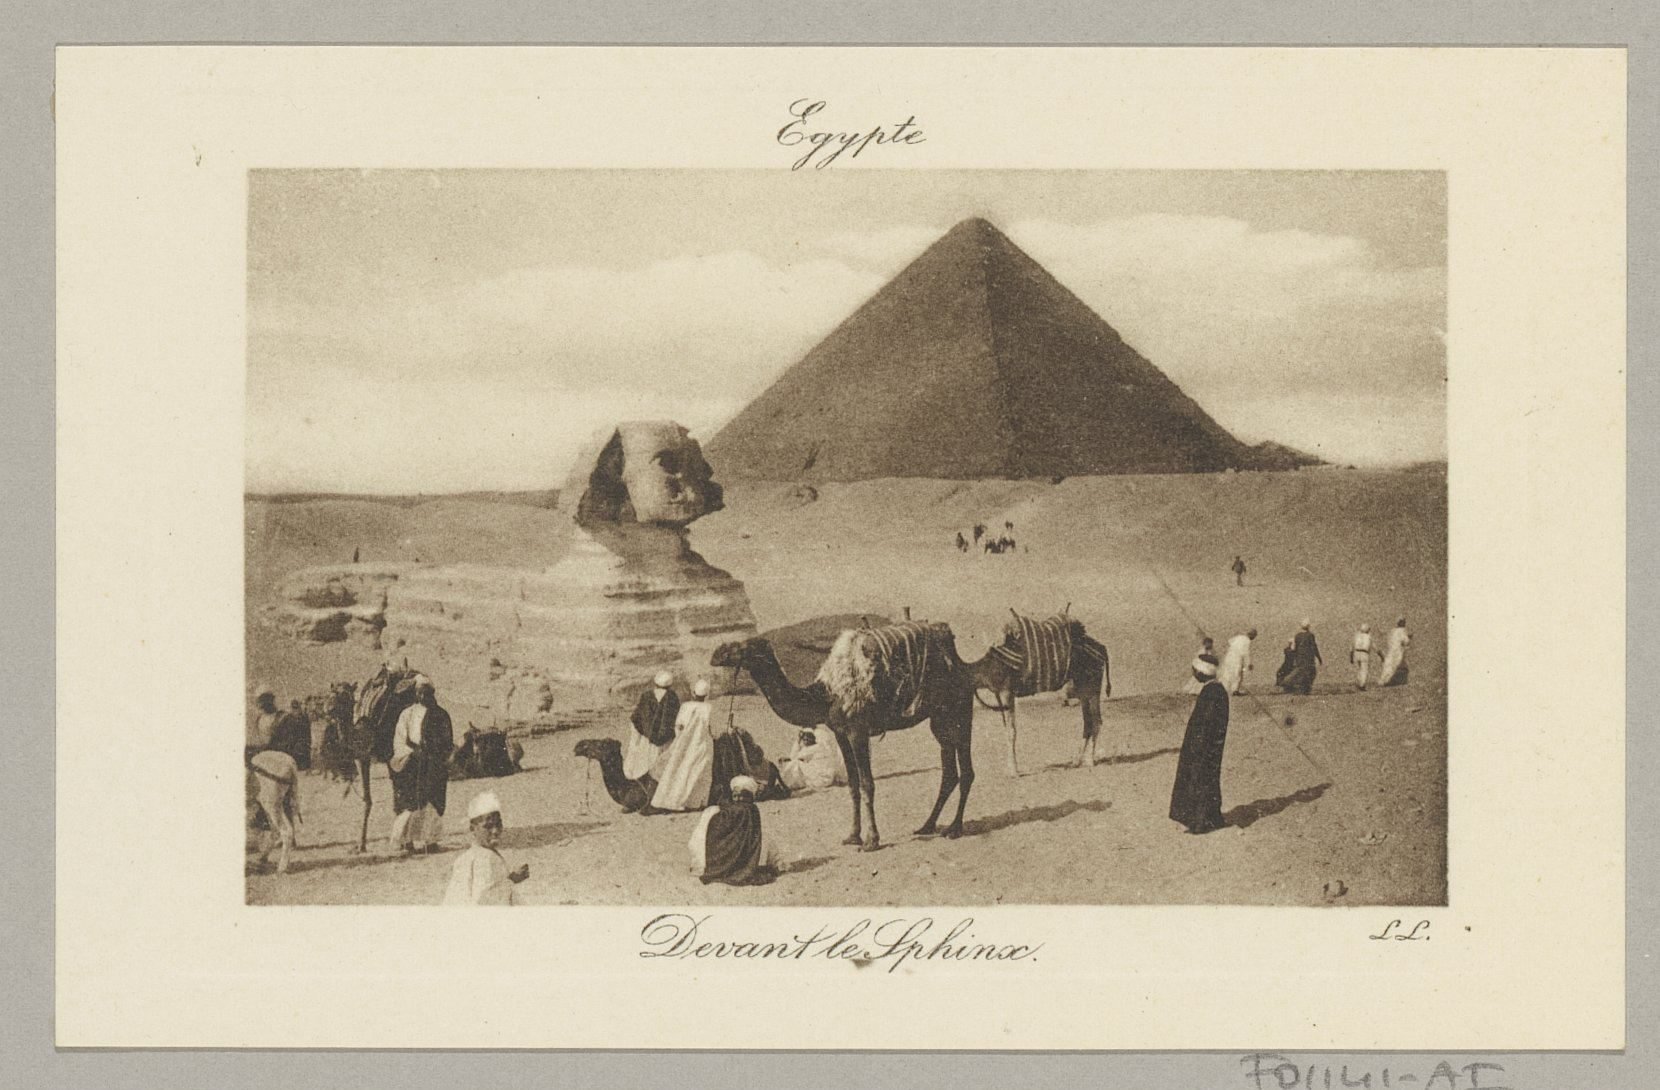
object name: photomechanical print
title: Mannen met kamelen bij de Piramide van Chefren en de Sfinx van Gizeh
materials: paper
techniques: photograph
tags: sphinx (lion/woman); 'sfinge' (ripa) - aa - female human figure, pyramid (historical grave form)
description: Onderdeel van Fotoalbum van een reis door Zuid-Europa en het Midden-Oosten.